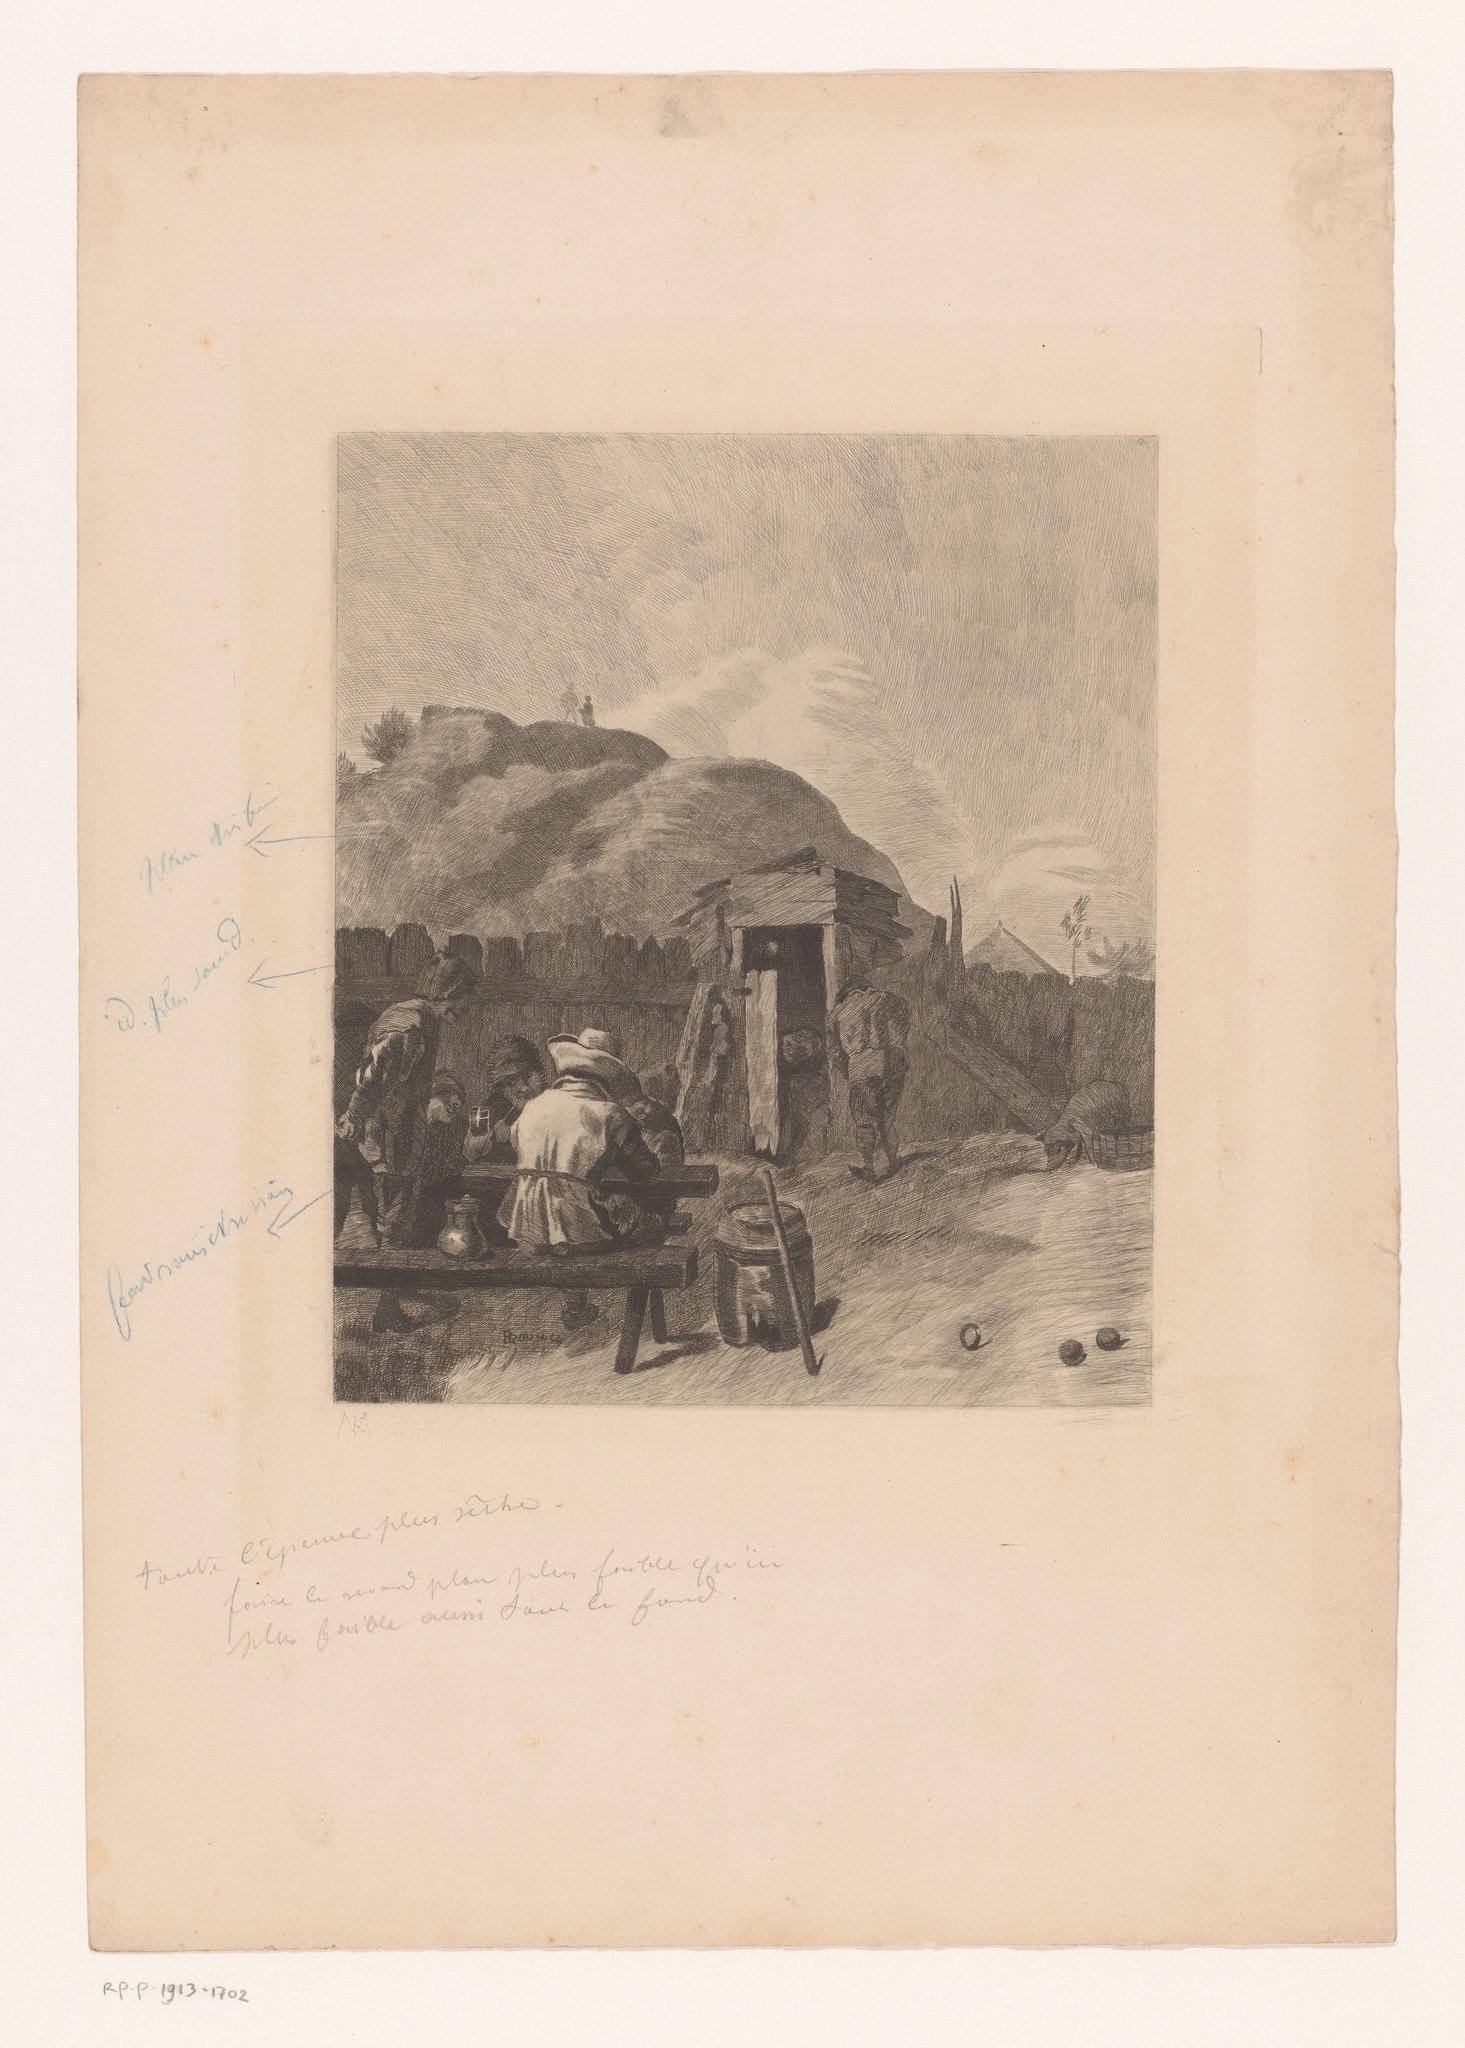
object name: print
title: Kaartspelers buiten bij een tafel met heuvel op de achtergrond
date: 1874-1894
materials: paper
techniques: etching, intaglio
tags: low hill country, fence, wall, paling, playing-cards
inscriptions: collector's mark: Lugt 2228, inscription